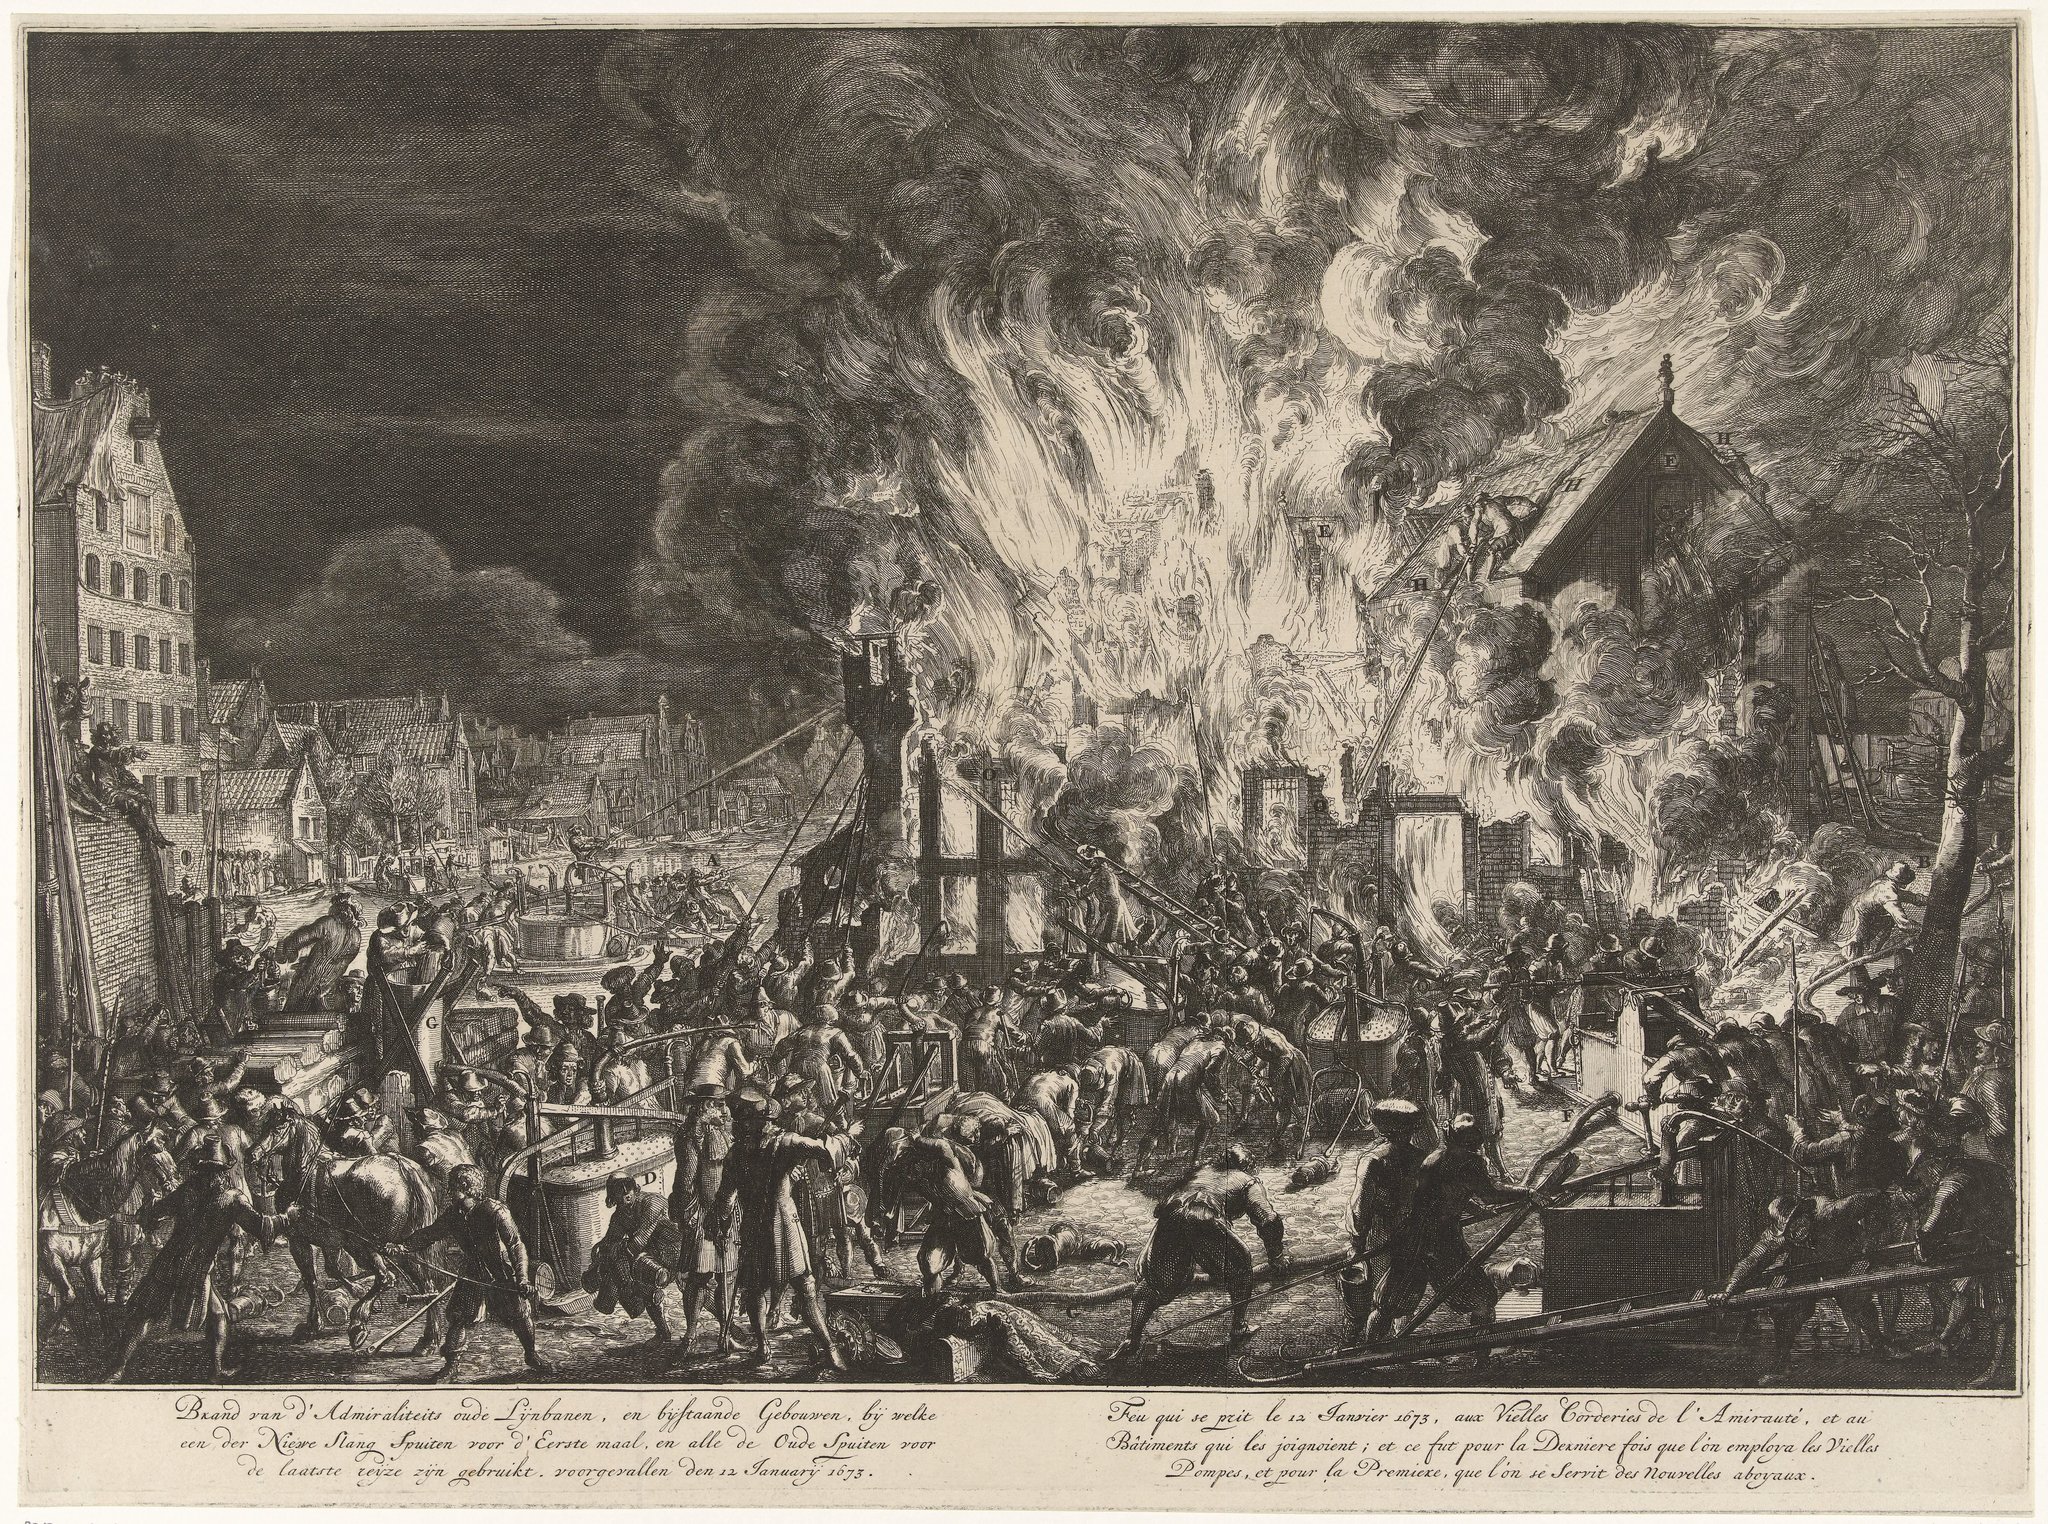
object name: print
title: Brand in de lijnbanen van de Admiraliteit, 1673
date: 1690-1735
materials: paper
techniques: engraving, etching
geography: northern netherlands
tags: painter, print maker, draughtsman, jan van der heyden, on fire, ablaze, fire-fighting, fire-extinguishing equipment, amsterdam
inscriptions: collector's mark: Lugt 2228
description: Prent ook gebruikt in: Heyden, Jan van der. Beschryving der nieuwlyks uitgevonden en geoctrojeerde slang-brand-spuiten en haare wyze van brand-blussen, tegenwoordig binnen Amsterdam in gebruik zijnde (…). 1e druk. Amsterdam: Jan Rieuwertsz. (II), 1690. En in: Heyden, Jan van der. Beschryving der nieuwlyks uitgevonden en geoctrojeerde slang-brand-spuiten en haare wyze van brand-blussen, tegenwoordig binnen Amsterdam in gebruik zijnde (…). 2e druk. Amsterdam: erfgenamen Jan van der Heyden, 1735. Voor eerdere staat, voor de letter, zie RP-P-1884-A-7672. Voor andere exemplaren van geletterde staat, zie RP-P-AO-25-61, RP-P-AO-28-76-4 en RP-P-OB-77.744.